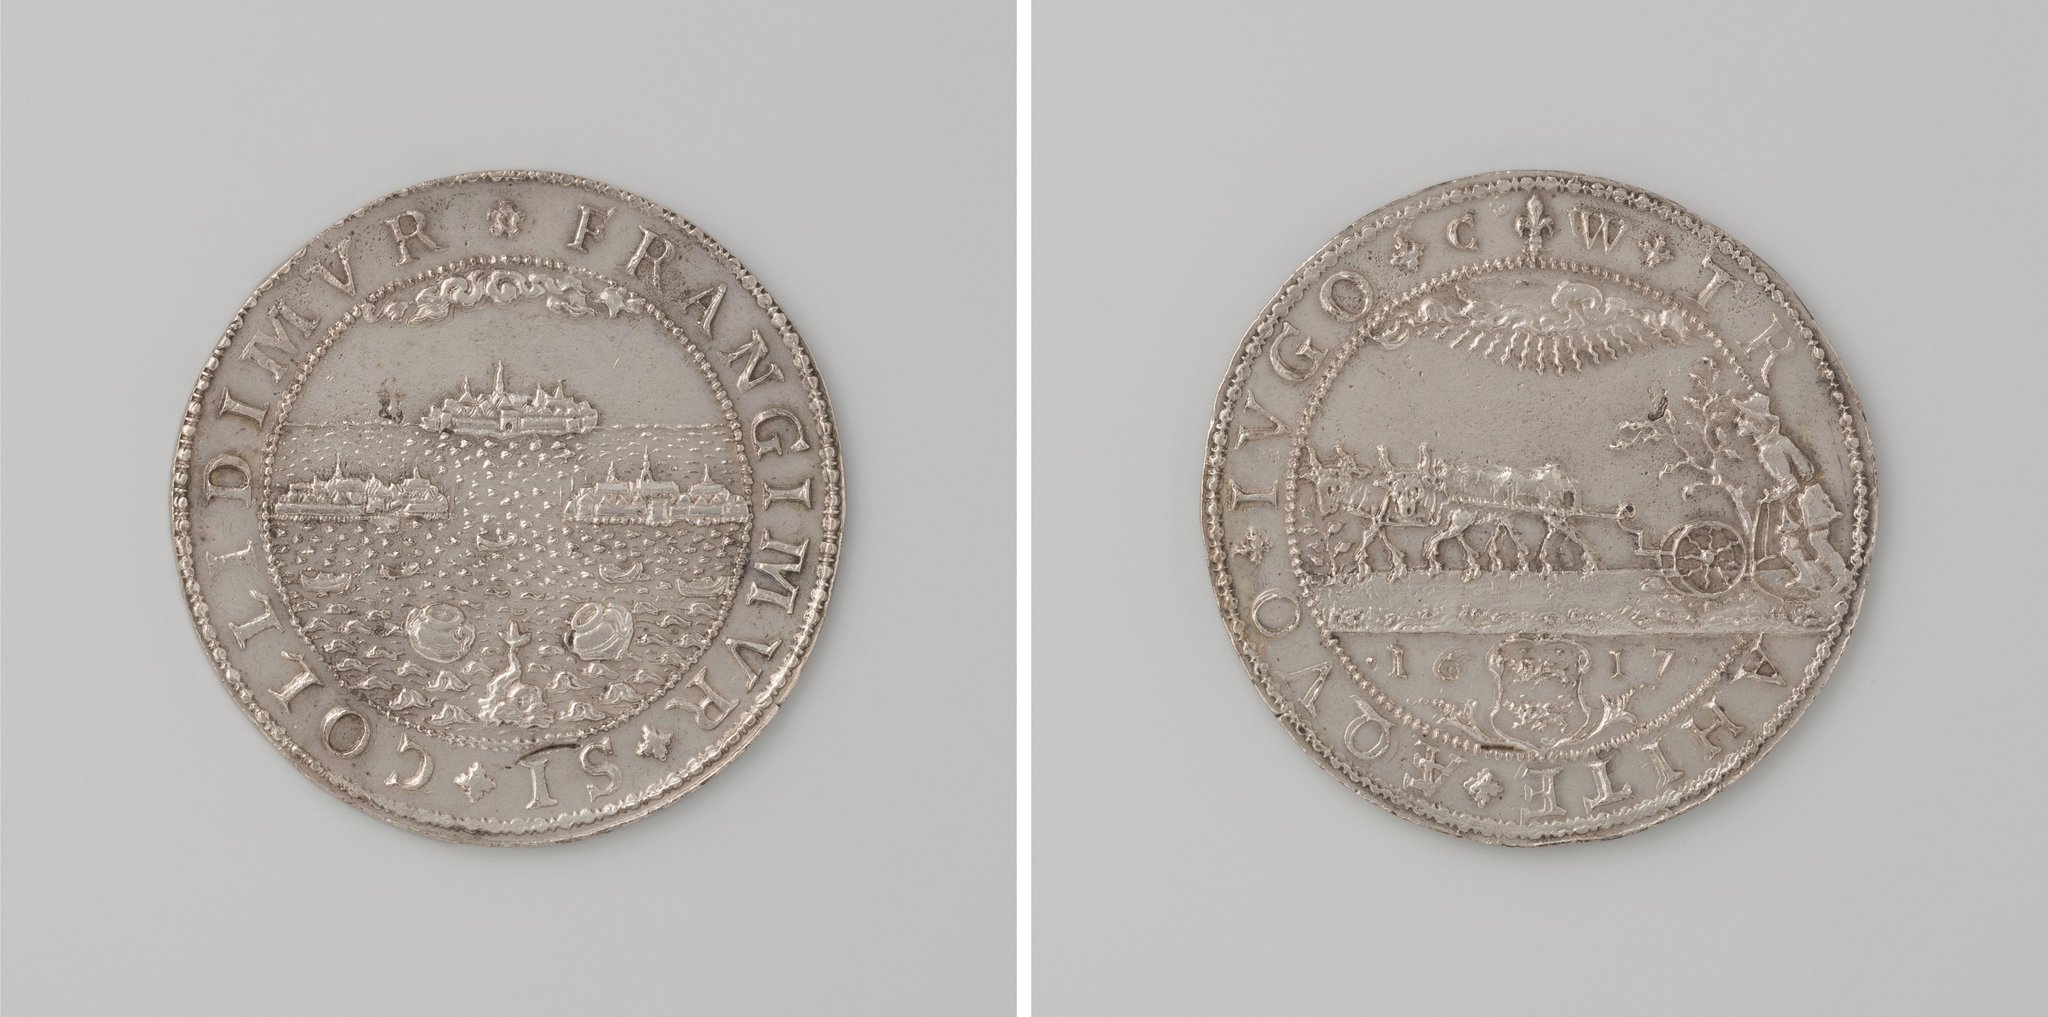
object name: triomfpenning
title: Aansporing tot eenheid in West-Friesland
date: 1617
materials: silver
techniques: striking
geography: west frisia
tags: enkhuizen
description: Zilveren penning. Voorzijde: drie steden aan water, op voorgrond bootjes, twee potten en vis binnen omschrift. Keerzijde: span ossen voor ploeg boven wapenschild (West-Friesland) binnen omschrift